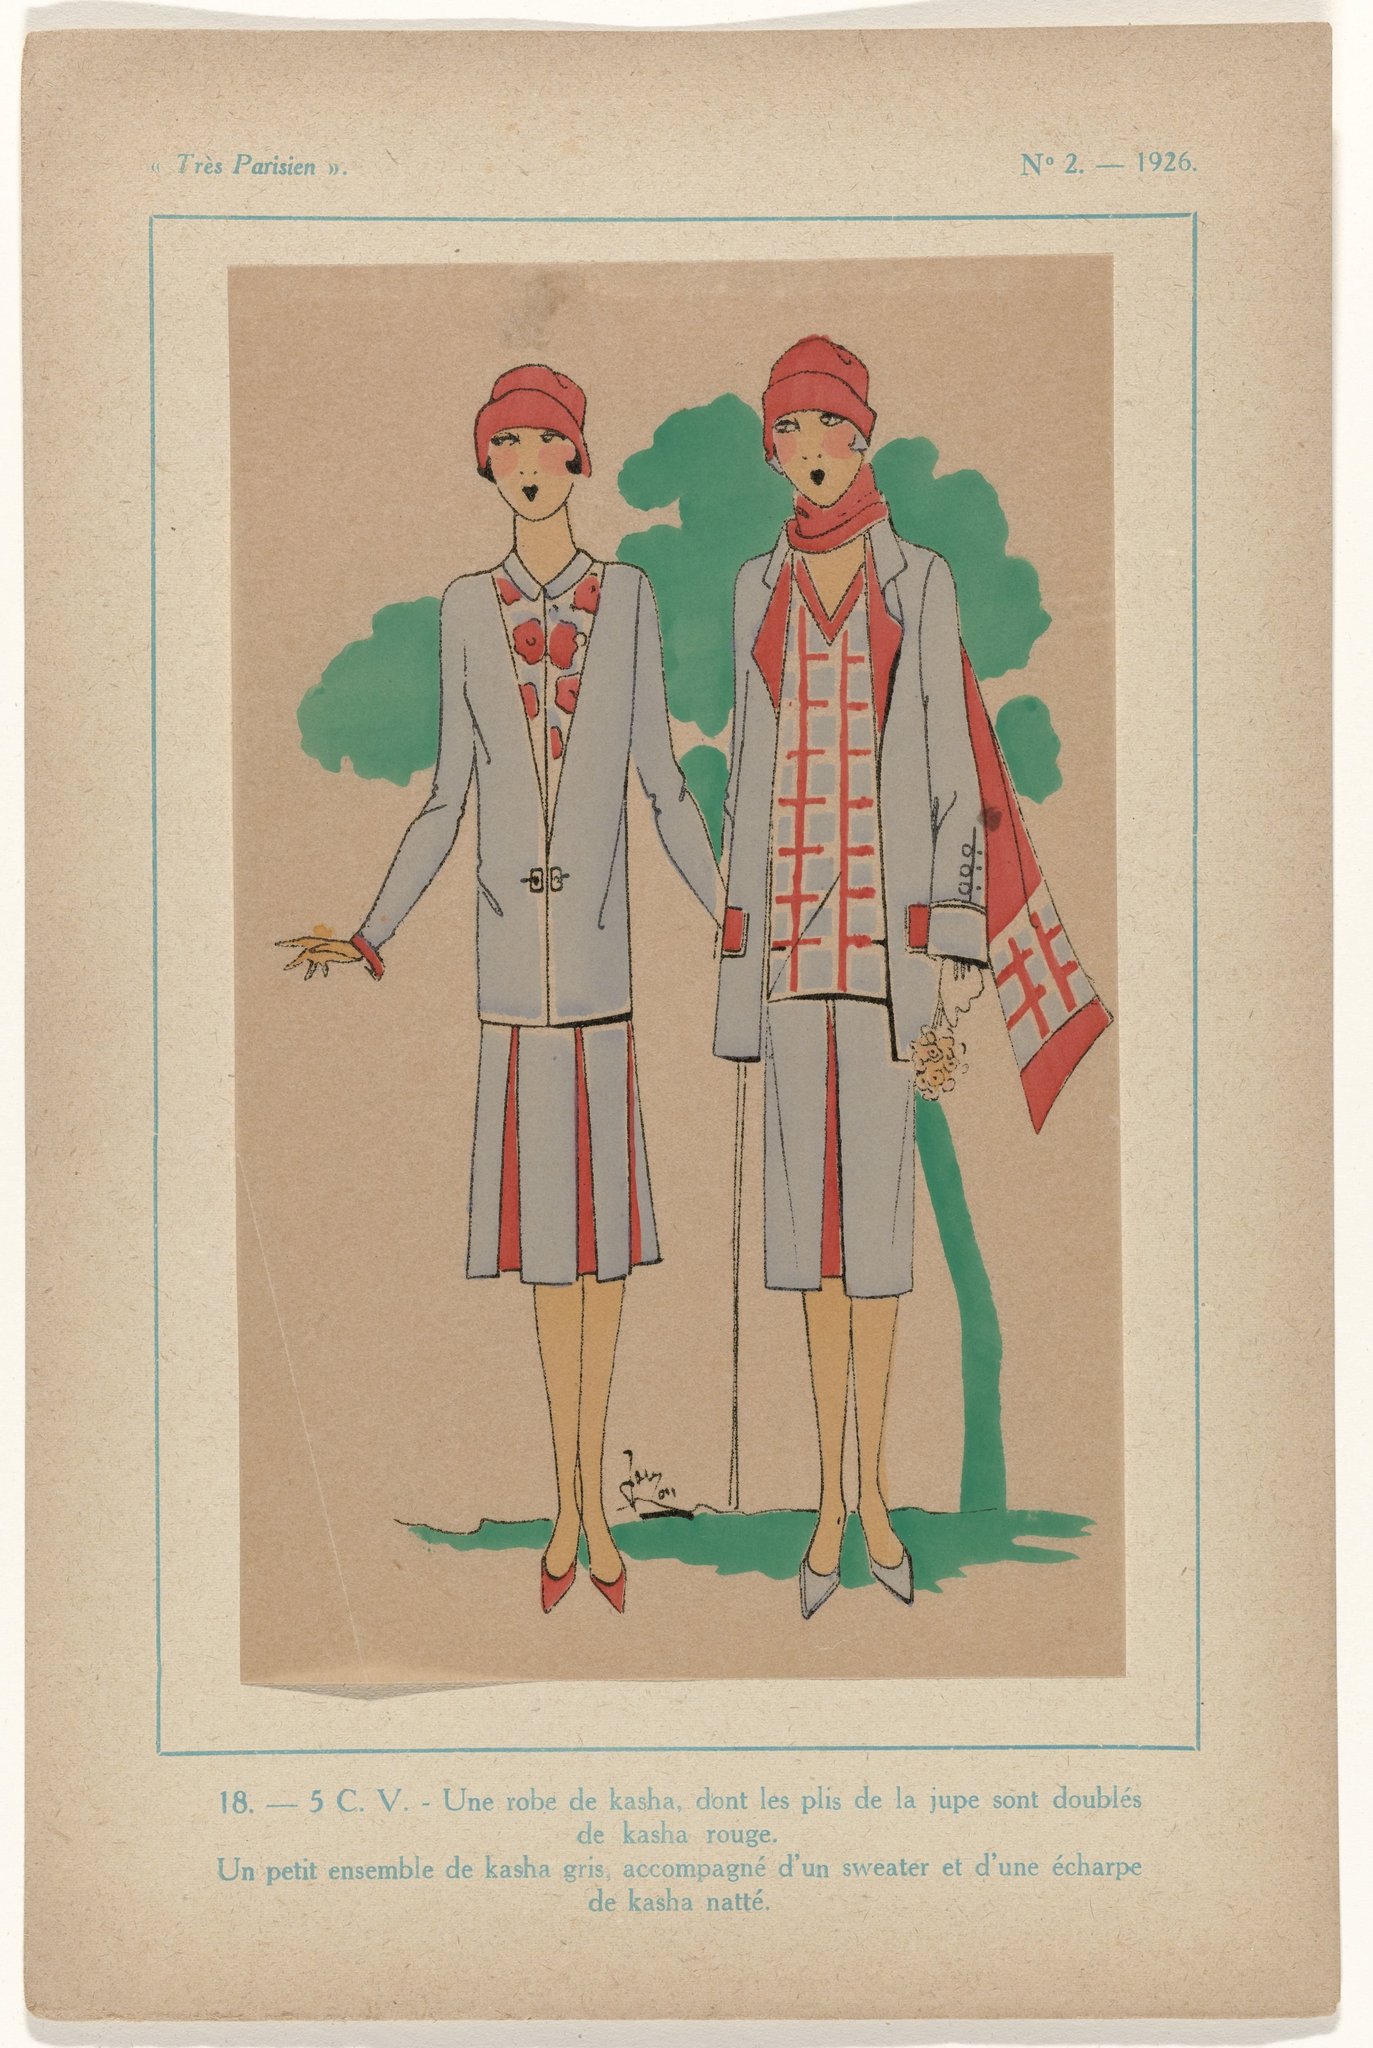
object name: fashion print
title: Très Parisien, 1926, No. 2, Pl. 18: - 5 C.V. Une robe de kash (...)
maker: g-p. joumard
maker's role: publisher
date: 1926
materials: paper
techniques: hand coloring, letterpress printing, lithography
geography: paris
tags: dress, gown: day dress (+ women's clothes), ensemble of pieces of clothing (+ women's clothes), neck-gear ~ clothing (shawl) (+ women's clothes), fashion plates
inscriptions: caption: ‘5. C.V. Une robe de kasha, dont les plis de la jupe sont doublés de kasha rouge. Un petit ensemble de kasha gris, accompagné d'un sweater et d'une écharpe de kasha natté.’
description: Japon en ensemble van grijs 'kasha'. Prent uit het modetijdschrift Très Parisien...La Mode, Le Chic, L'Élégance (1920-1936)